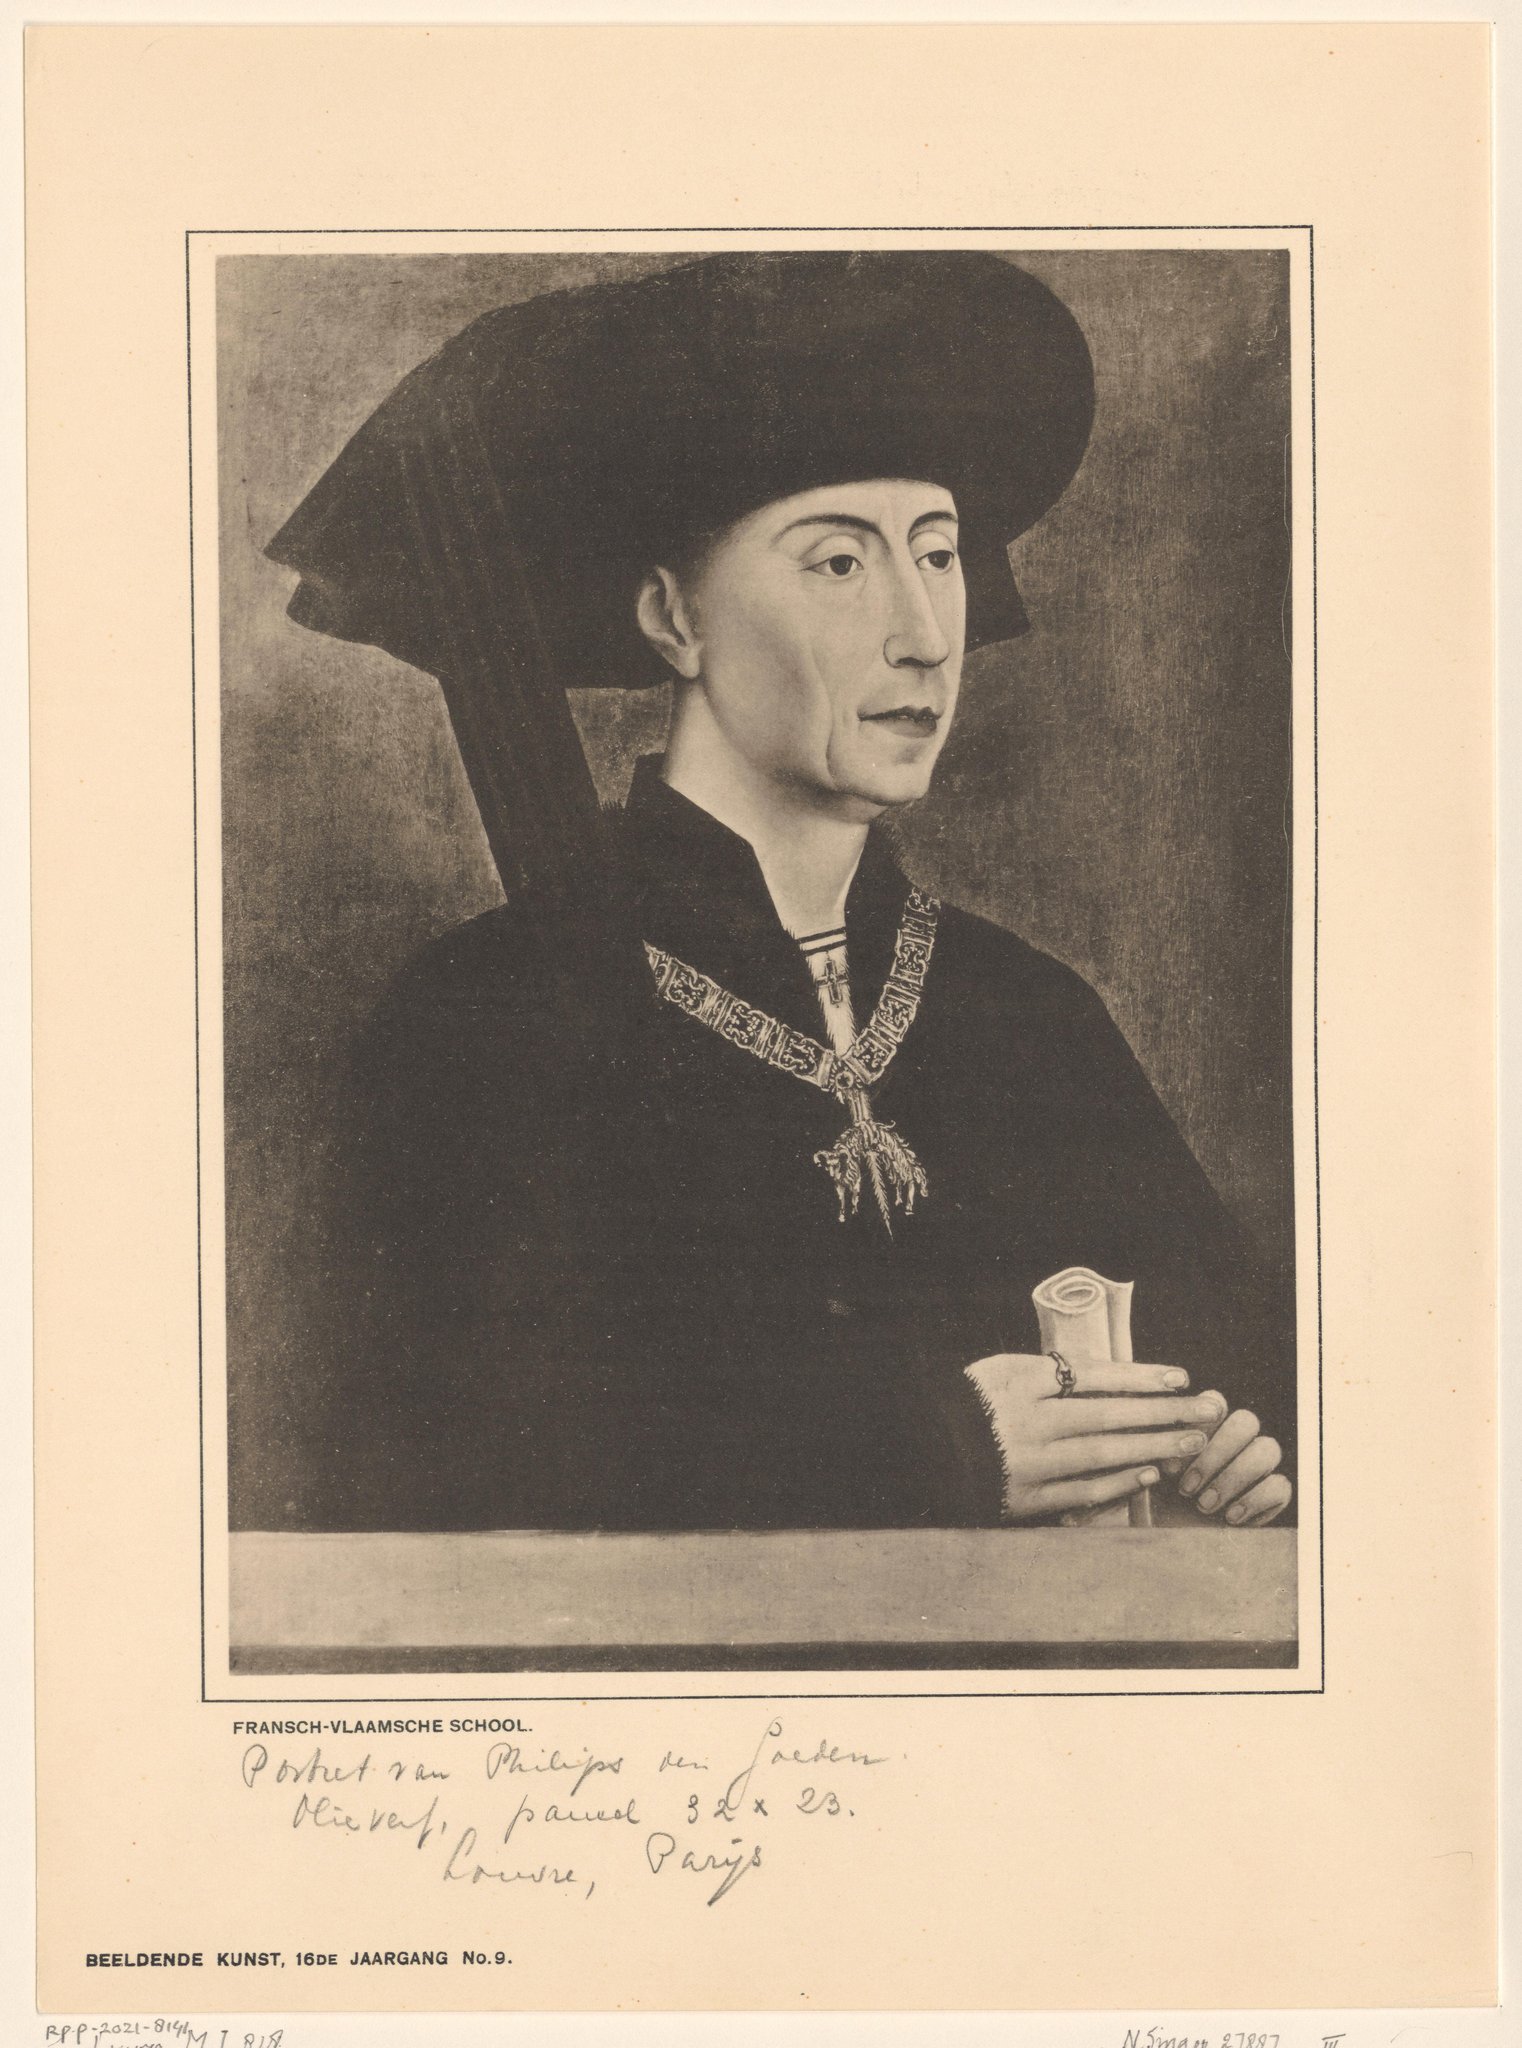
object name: photomechanical print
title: Portret van Filips de Goede, hertog van Bourgondië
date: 1929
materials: paper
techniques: photoaquatint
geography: utrecht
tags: bruges, philip iii the good, adult man, historical persons, knighthood order of the golden fleece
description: Prent uit: Beeldende Kunst (16) 1929, nr. 9.